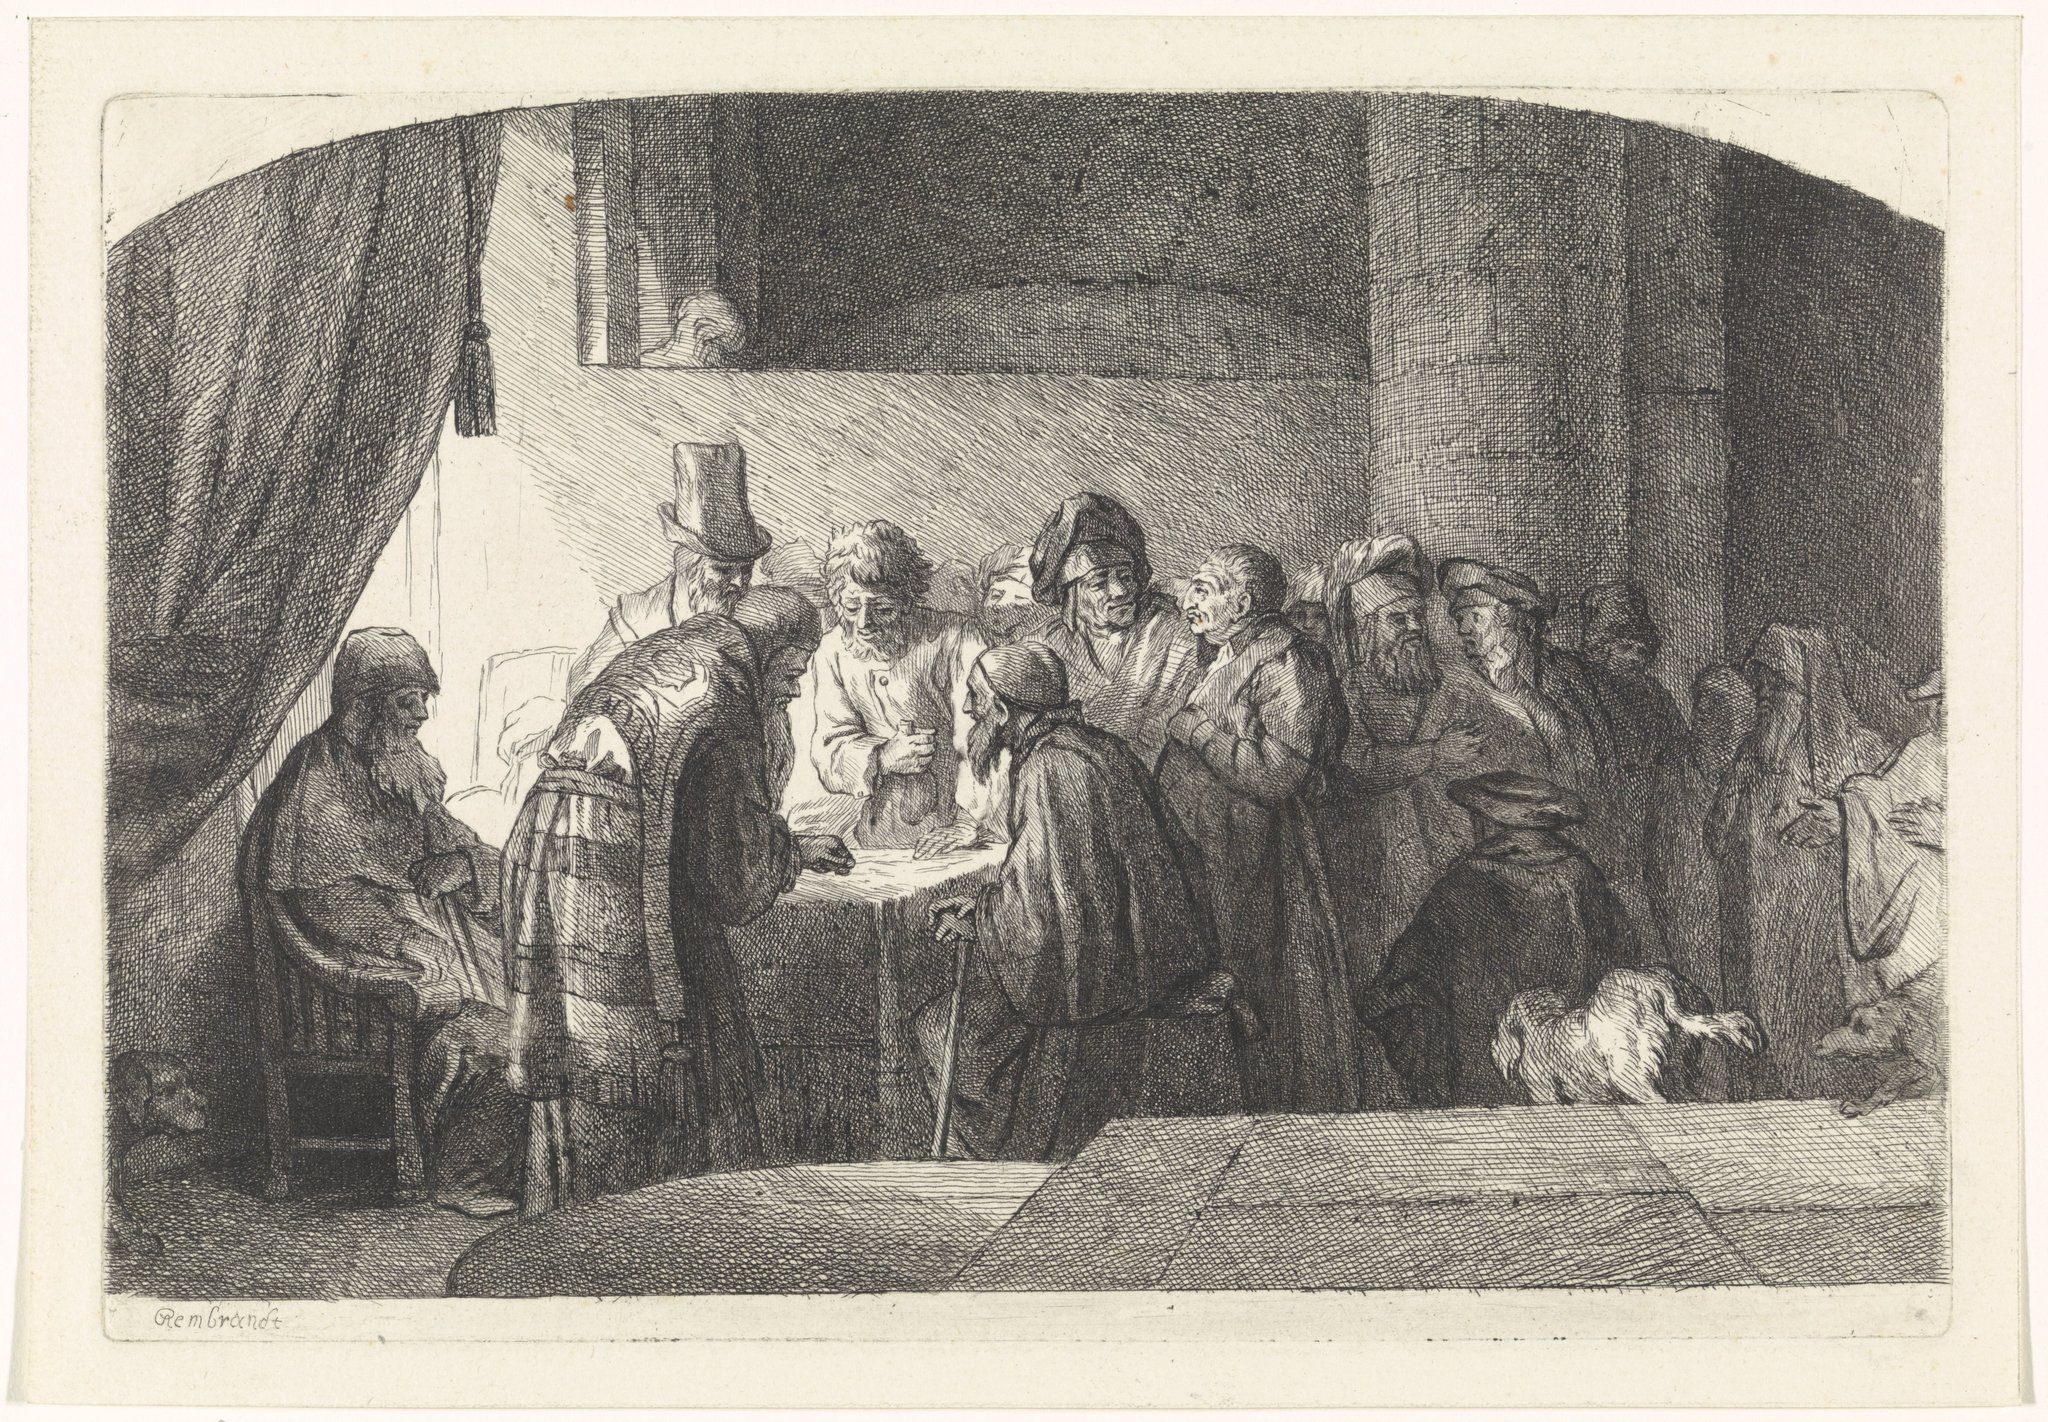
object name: print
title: Judas ontvangt zilverstukken voor zijn verraad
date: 1683-1733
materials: paper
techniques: etching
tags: judas goes out to the chief priests, betrays christ and receives the reward (matthew 26:14-16; mark 14:10-11; luke 22:4-6)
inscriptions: collector's mark: Lugt 240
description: Definitieve geletterde staat van deze prent opgenomen in: Impostures innocentes, ou recueil d'estampes d'apres divers peintres (...) par Bernard Picart (...) avec son elogue historique et le catalogue de ses ouvrages. Amsterdam: weduwe Bernard Picart, 1734.